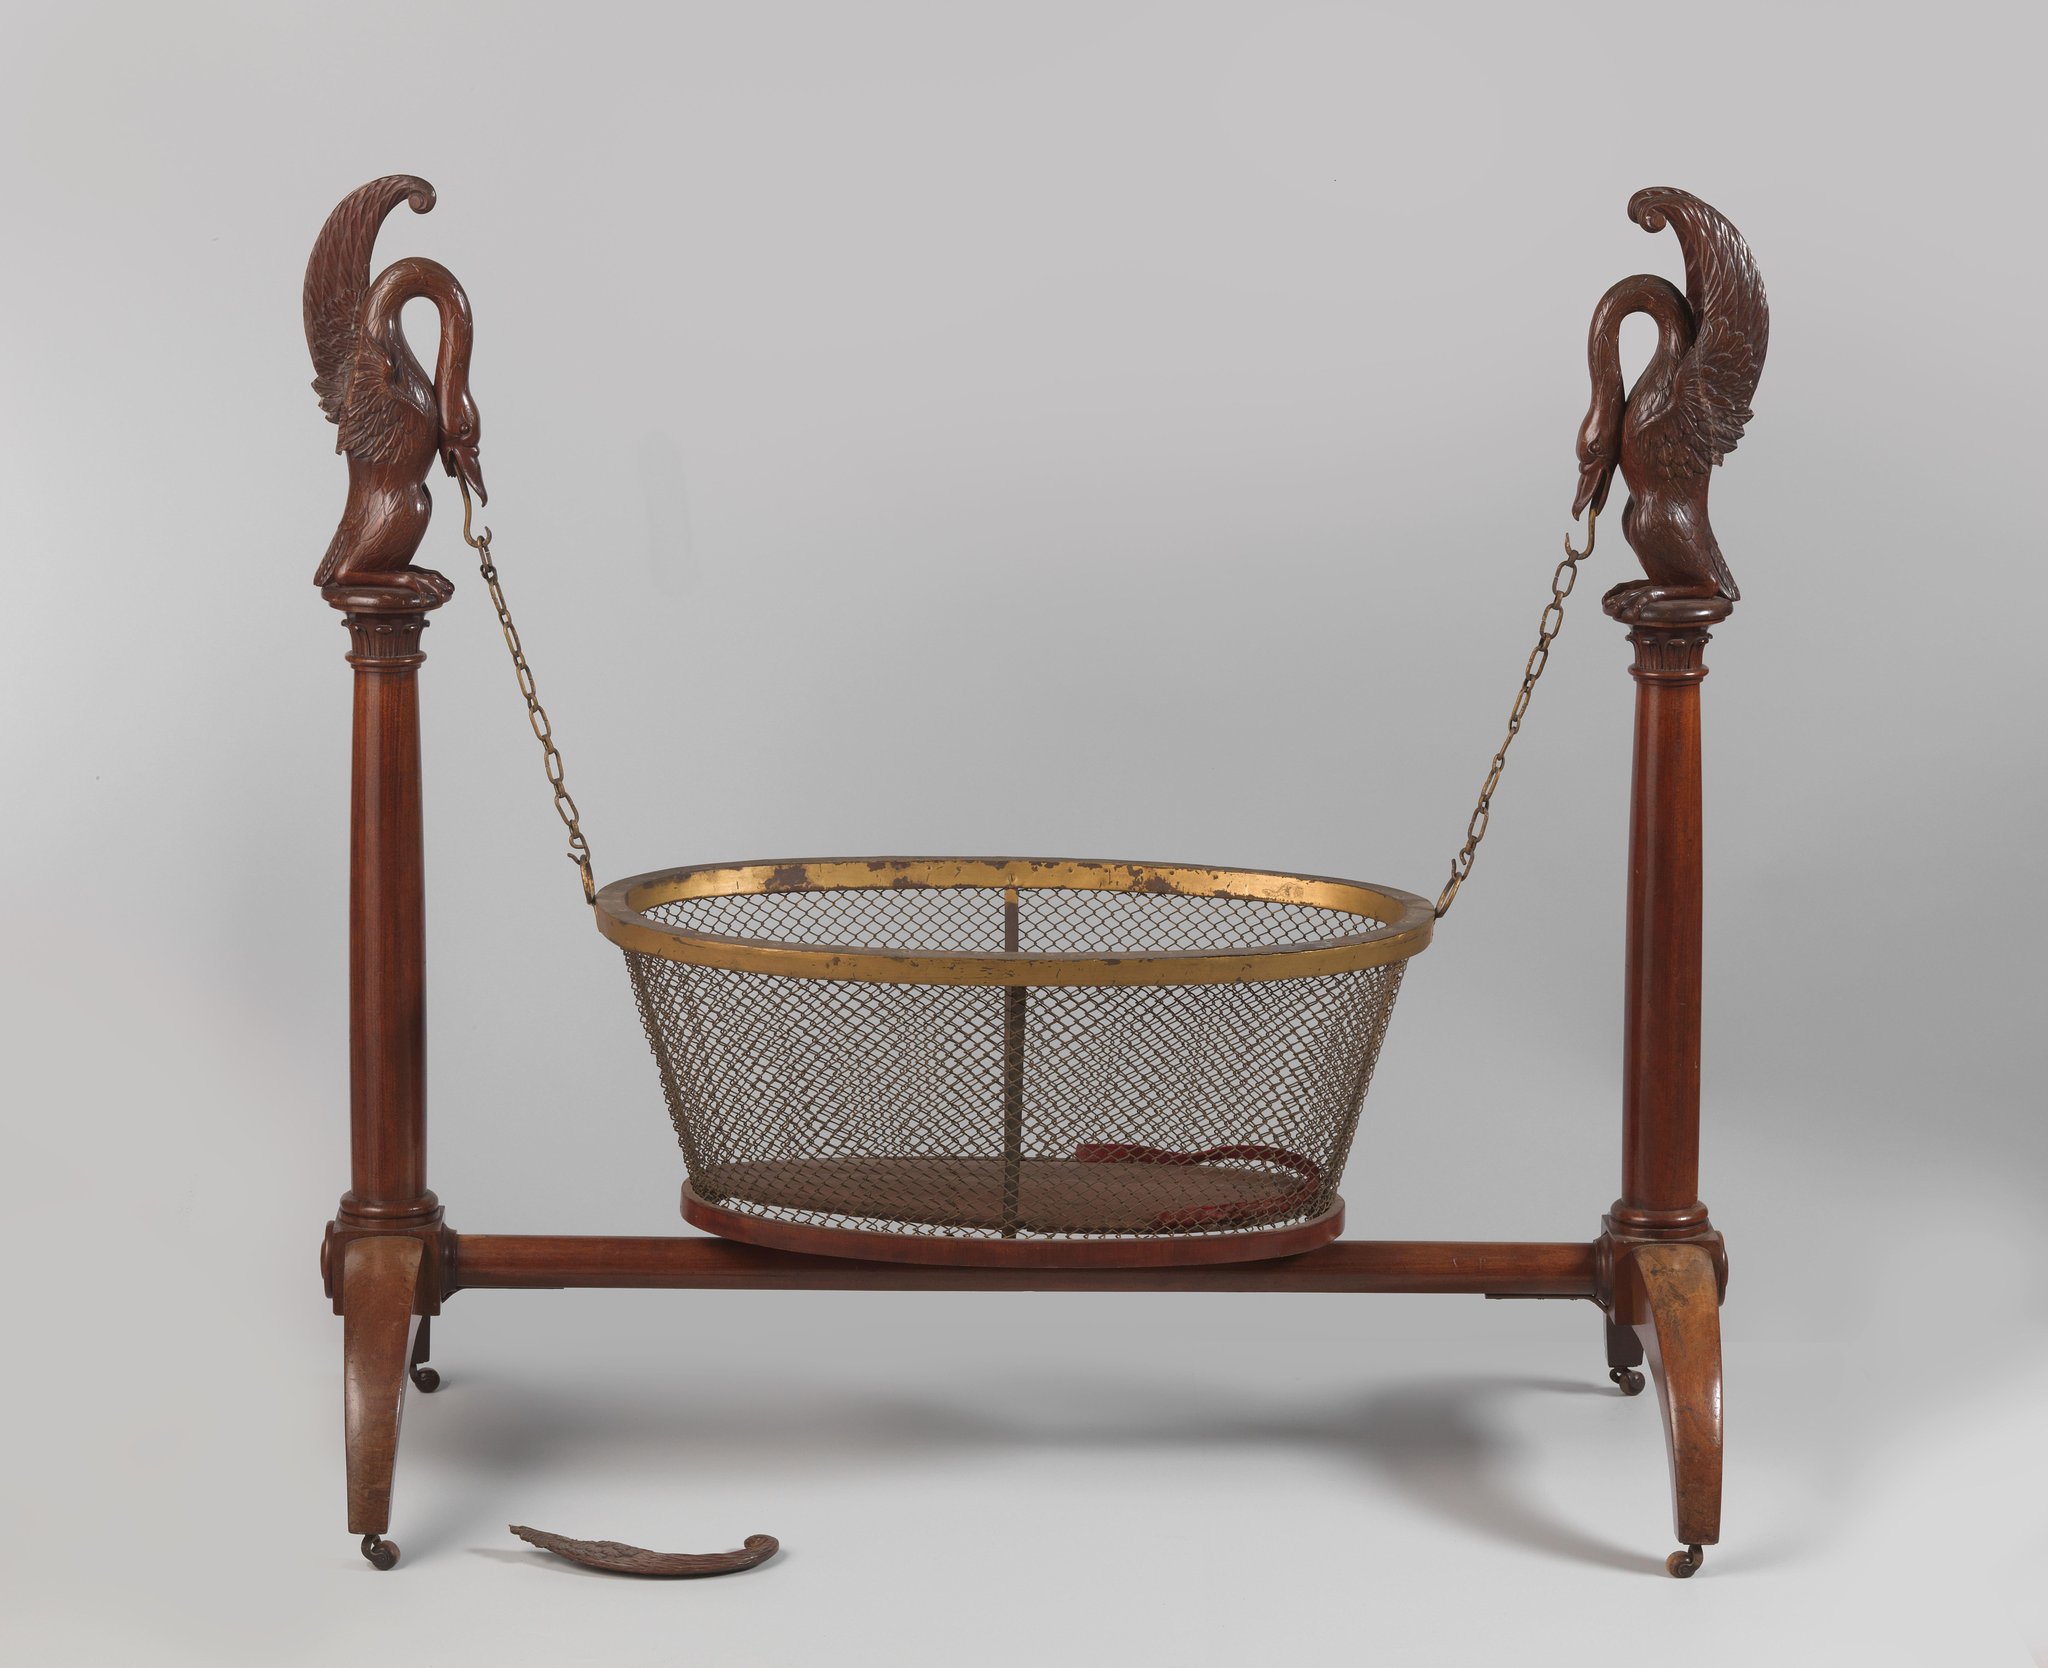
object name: column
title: Zuil, horend bij wieg, ovaal, van gevlochten koperdraad met lijstwerk van hout, hangend aan kettingen die bevestigd zijn aan de tongen van twee op een zuil zittende zwanen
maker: Anonymous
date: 1825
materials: copper, wood, metal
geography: france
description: Ovale wieg van uitgevlochten koperdraad, aan de boven- en onderzijde omgeven met houten banden, aan de bovenzijde belegd met metaal. Eikenhouten bodem. De wieg hangt met koperen kettingen aan de tongen van twee gebeeldhouwde zittende zwanen met sterk gebogen halzen en in voluten eindigende vleugels, die op zuilvormige zuilen zitten. Deze zijn geplaatst op halve cirkelvormige poten op wieltjes, door een cylindervormige stijl met elkaar verbonden. Mahoniehout en koper.